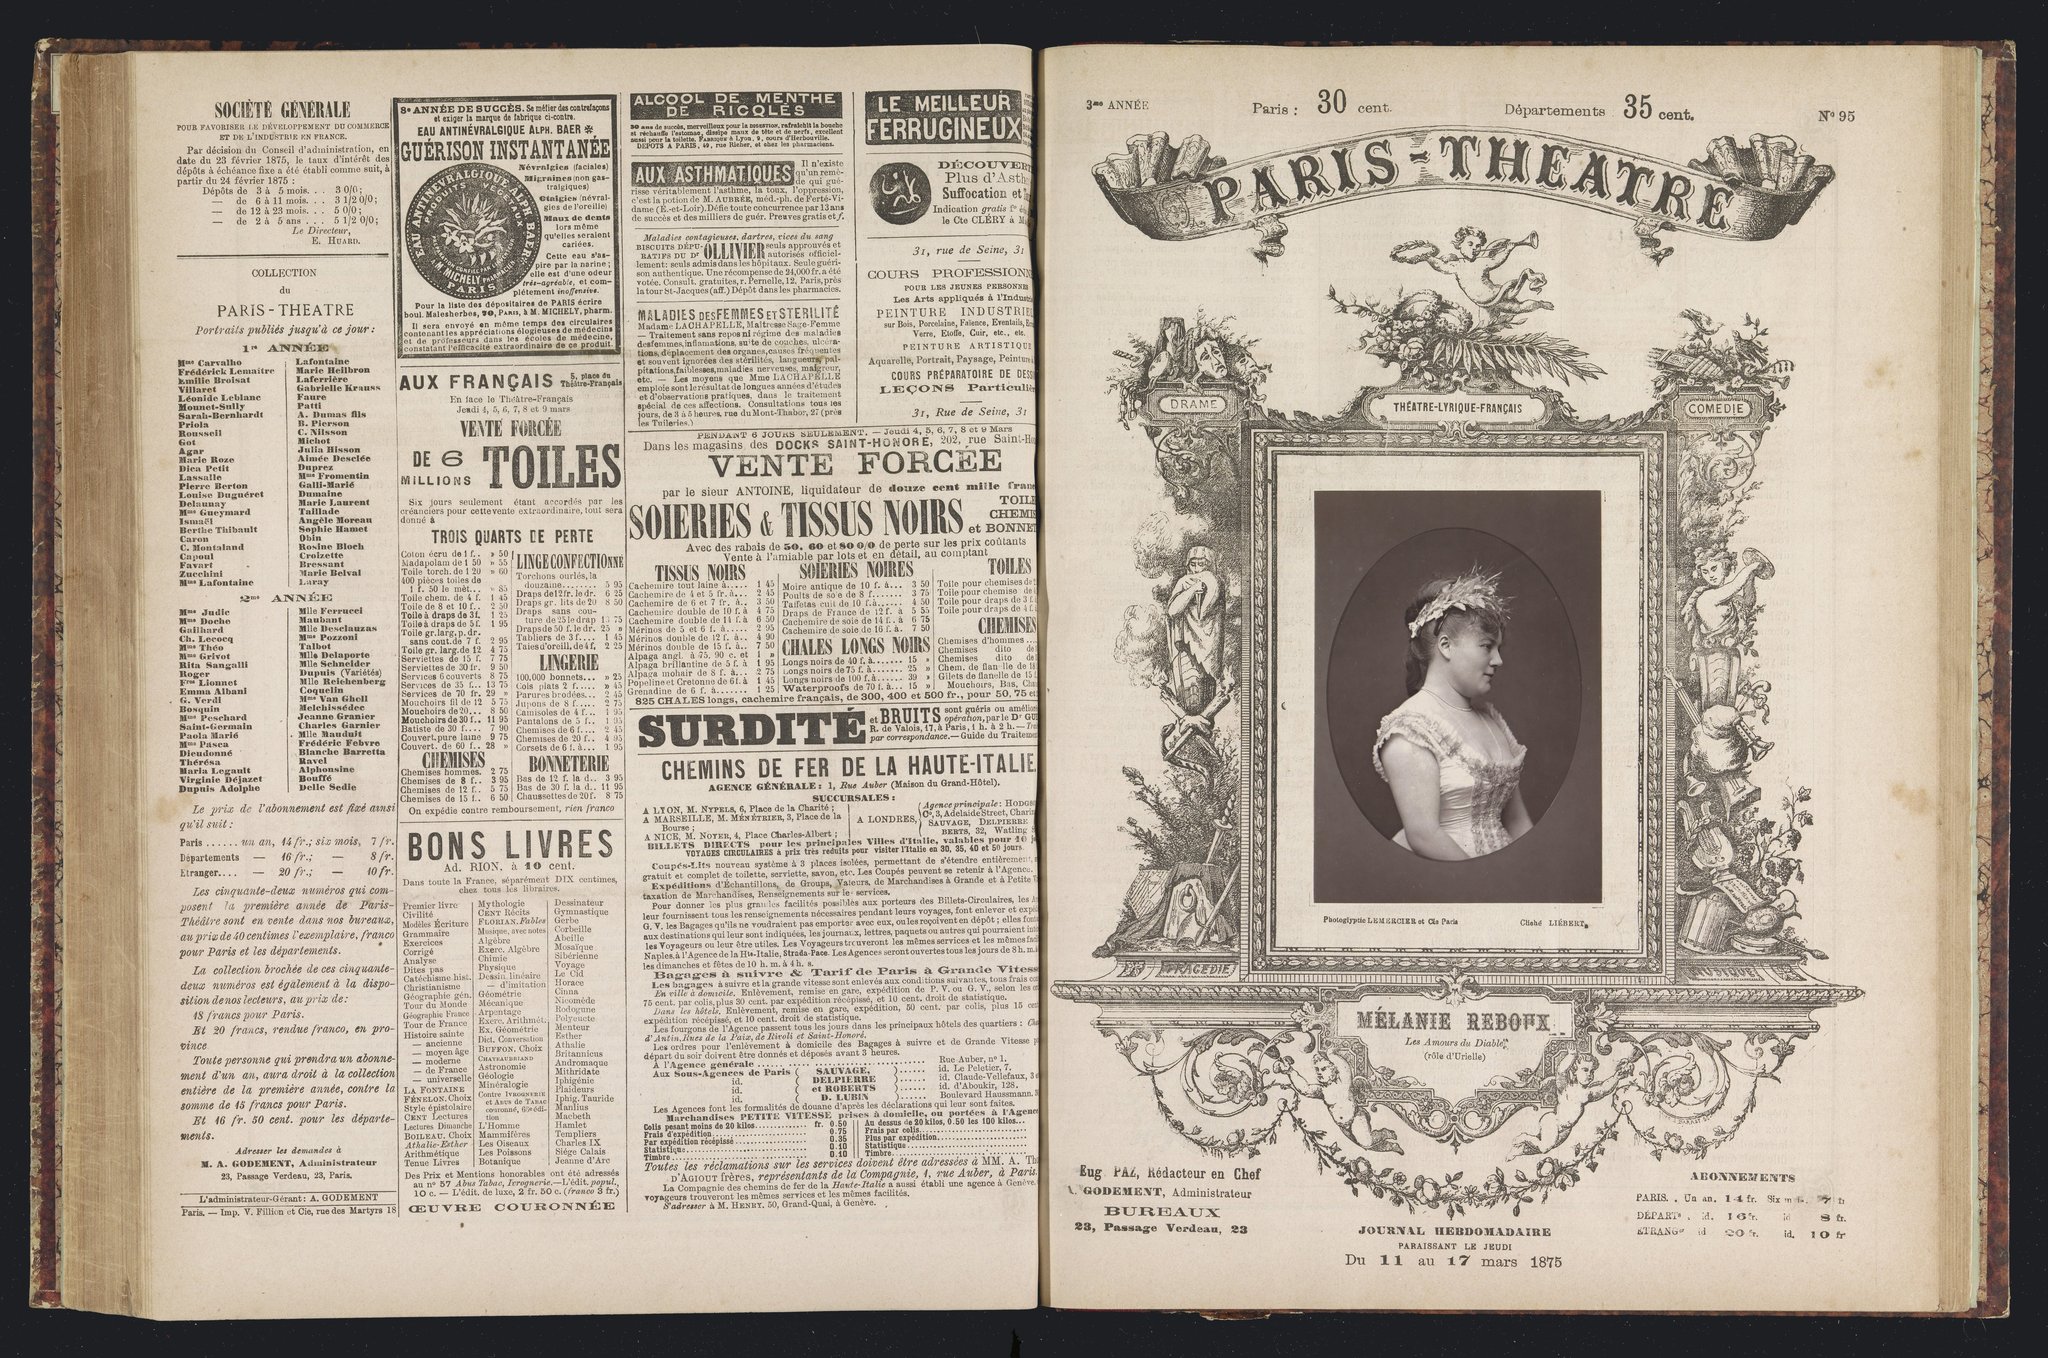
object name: photomechanical print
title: Mélanie Reboux Les Amours du Diable (rôle d'Urielle)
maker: alphonse-justin liébert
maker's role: fotograaf, marinier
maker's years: 1827-1914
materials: paper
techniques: woodburytype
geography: france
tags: portrait of opera-singer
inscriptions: inscription: ‘Journal hebdomadaire paraissant le jeudi Du 11 au 17 mars 1875’, number: ‘No 95’